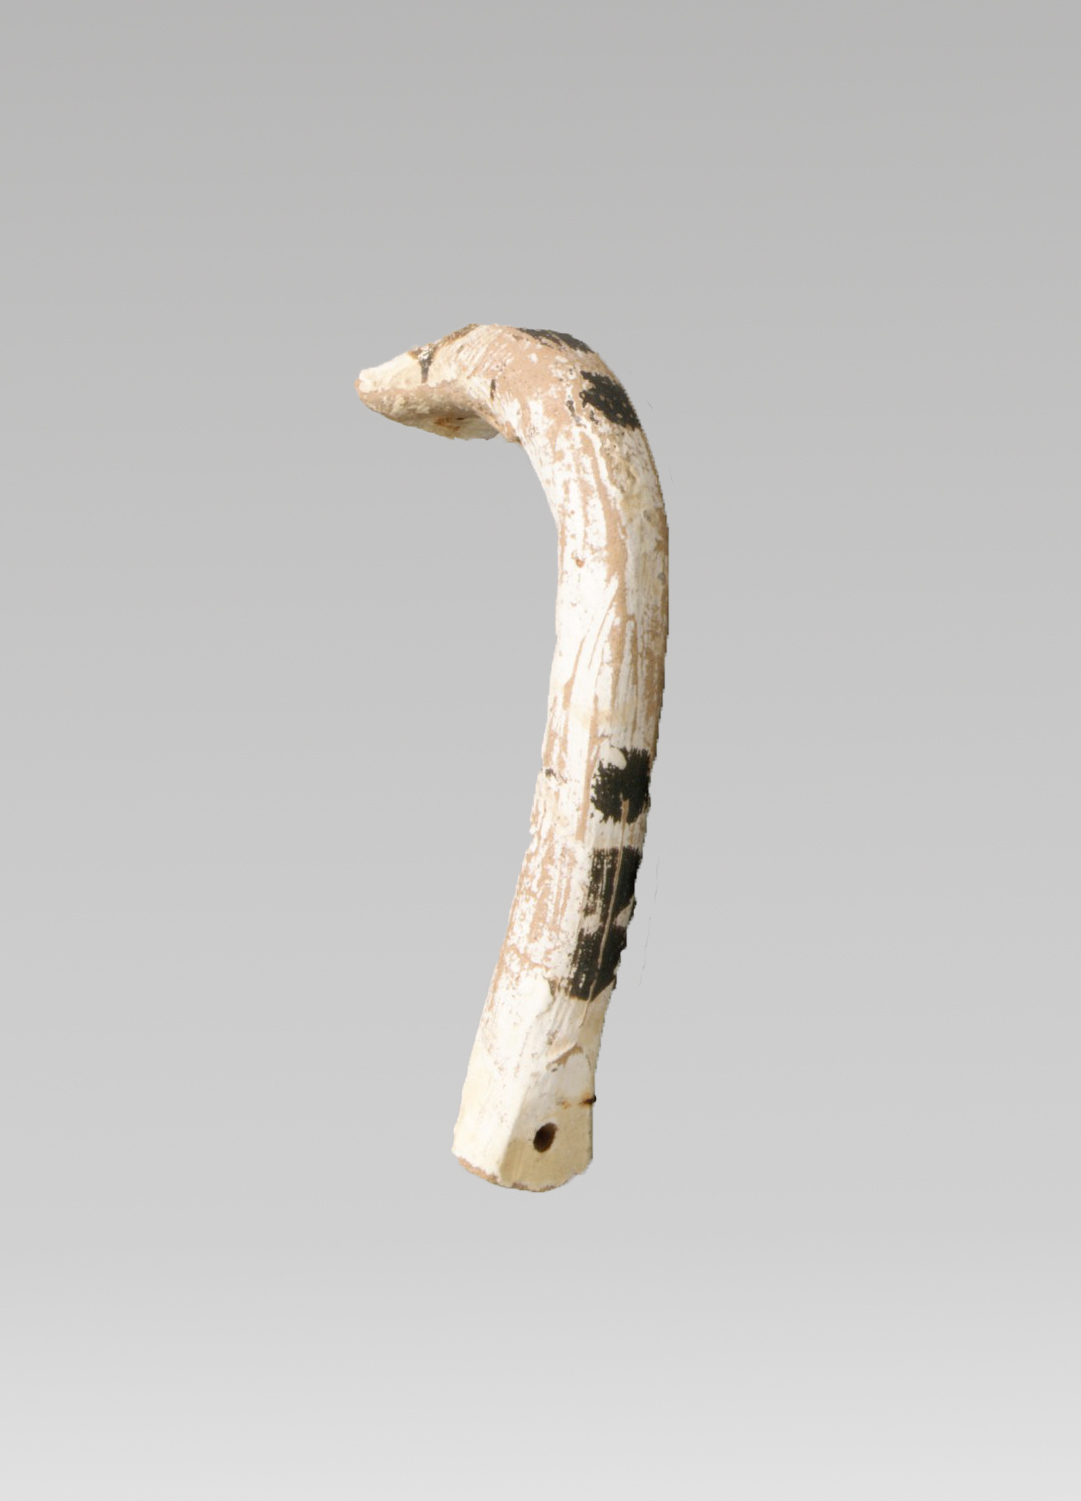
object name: vase fragment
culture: east greek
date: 700-601 BCE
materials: terracotta